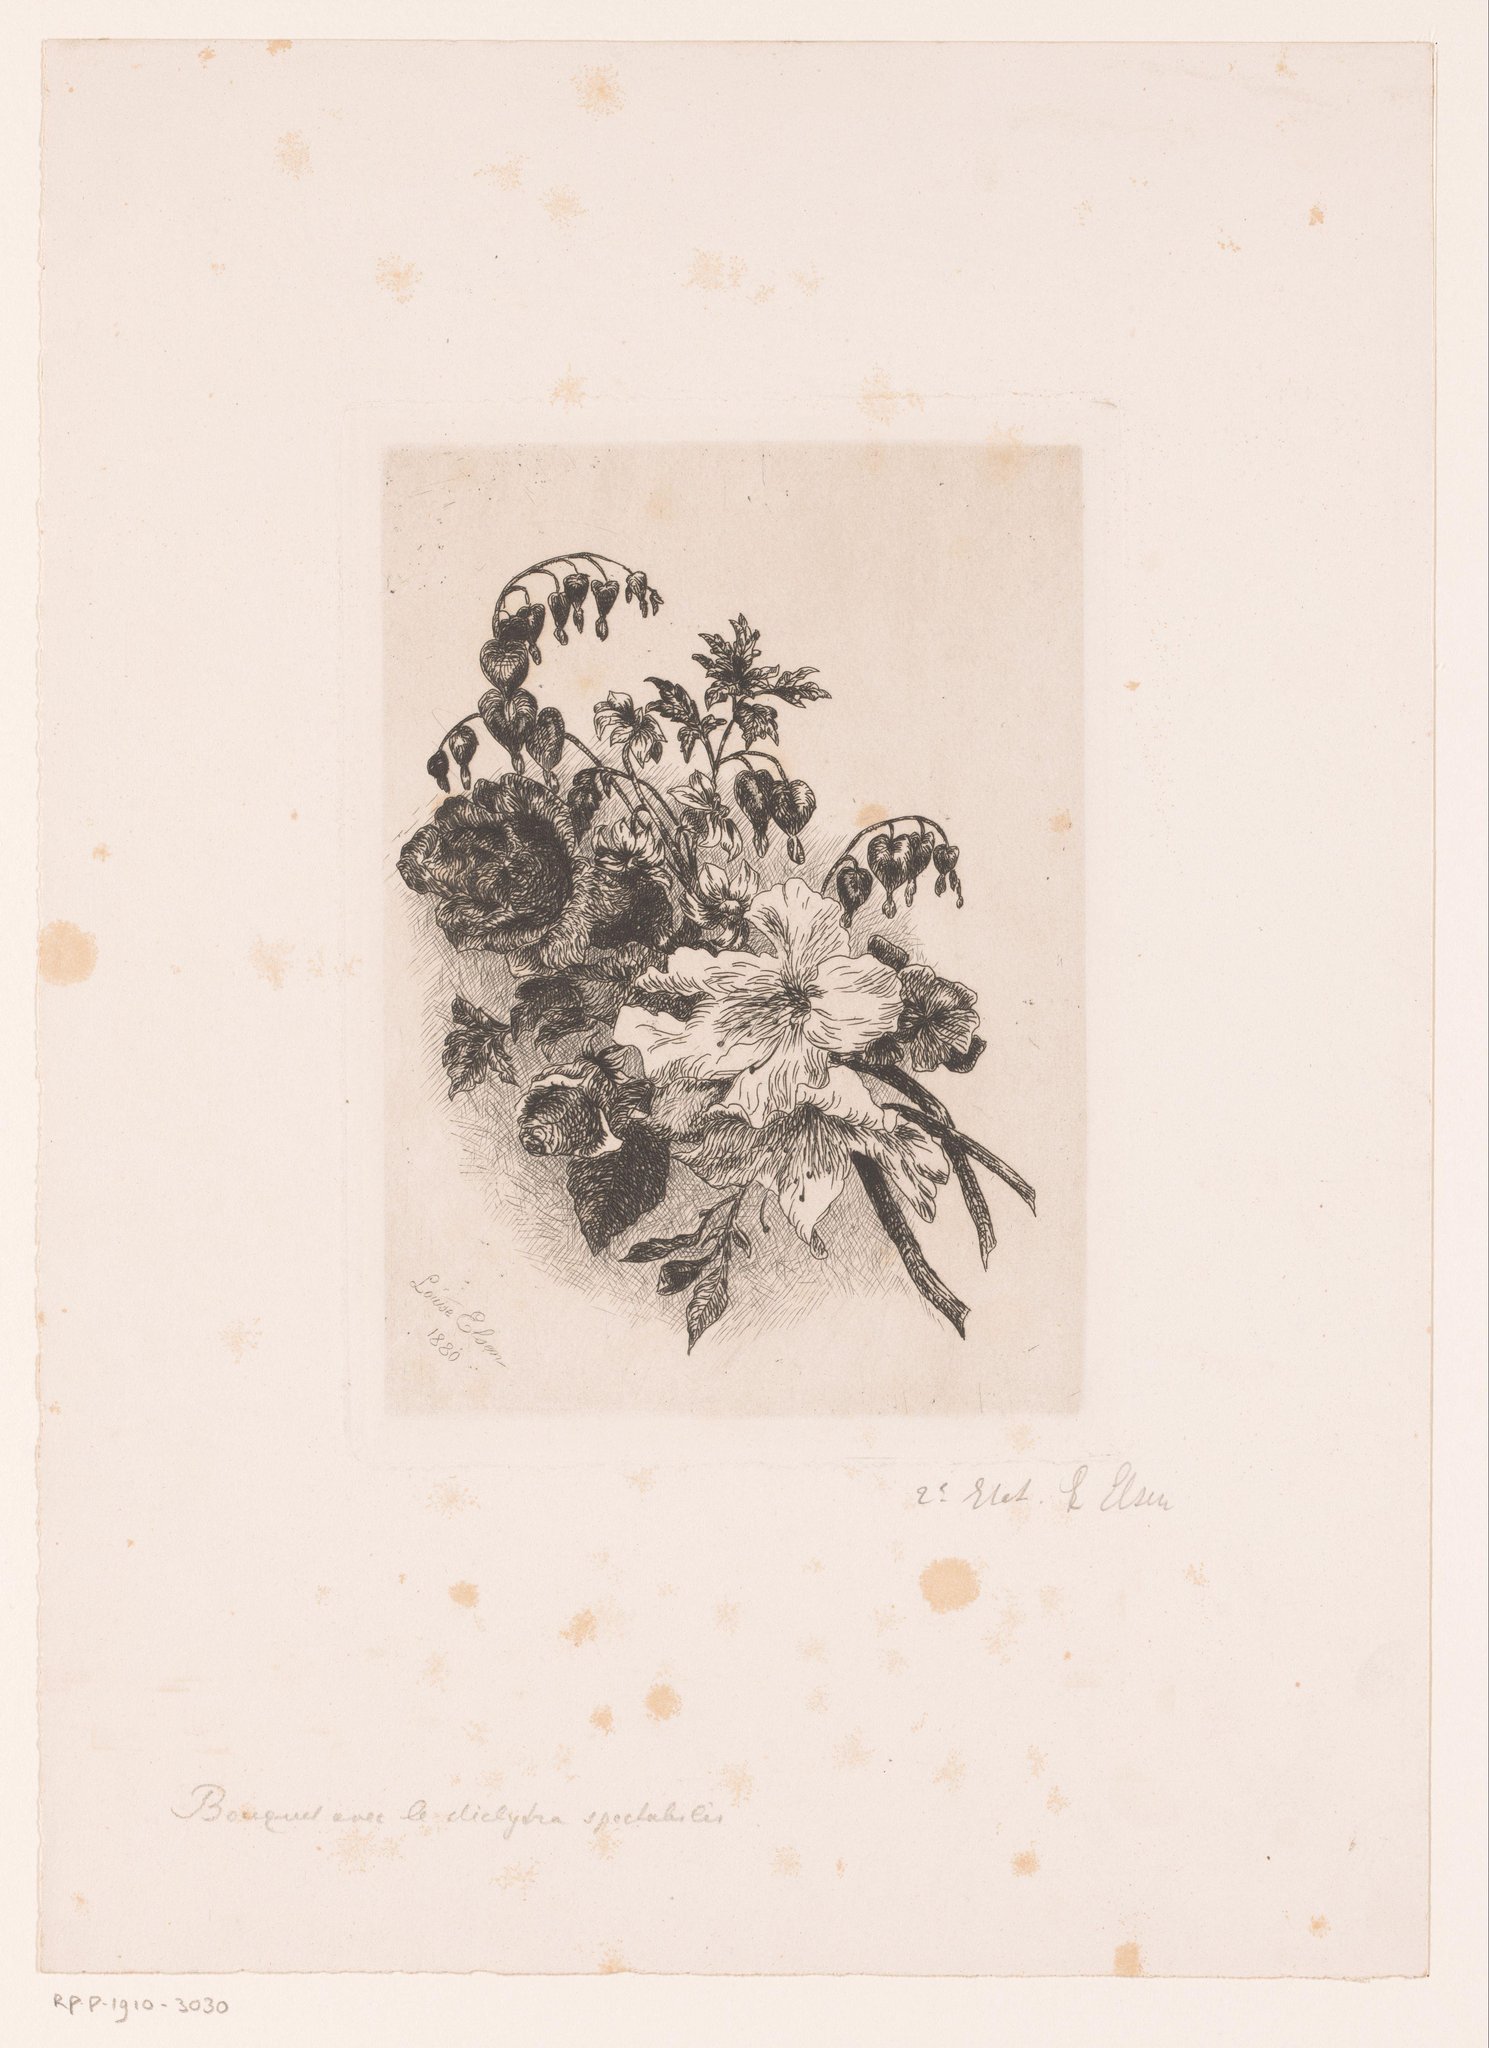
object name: print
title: Bloemstilleven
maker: louise elsen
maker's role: print maker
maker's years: 1853-1937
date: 1880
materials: paper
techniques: etching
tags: still life of plants, flowers and fruit, flowers: rose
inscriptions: collector's mark: Lugt 2228, inscription: ‘2e Etat’